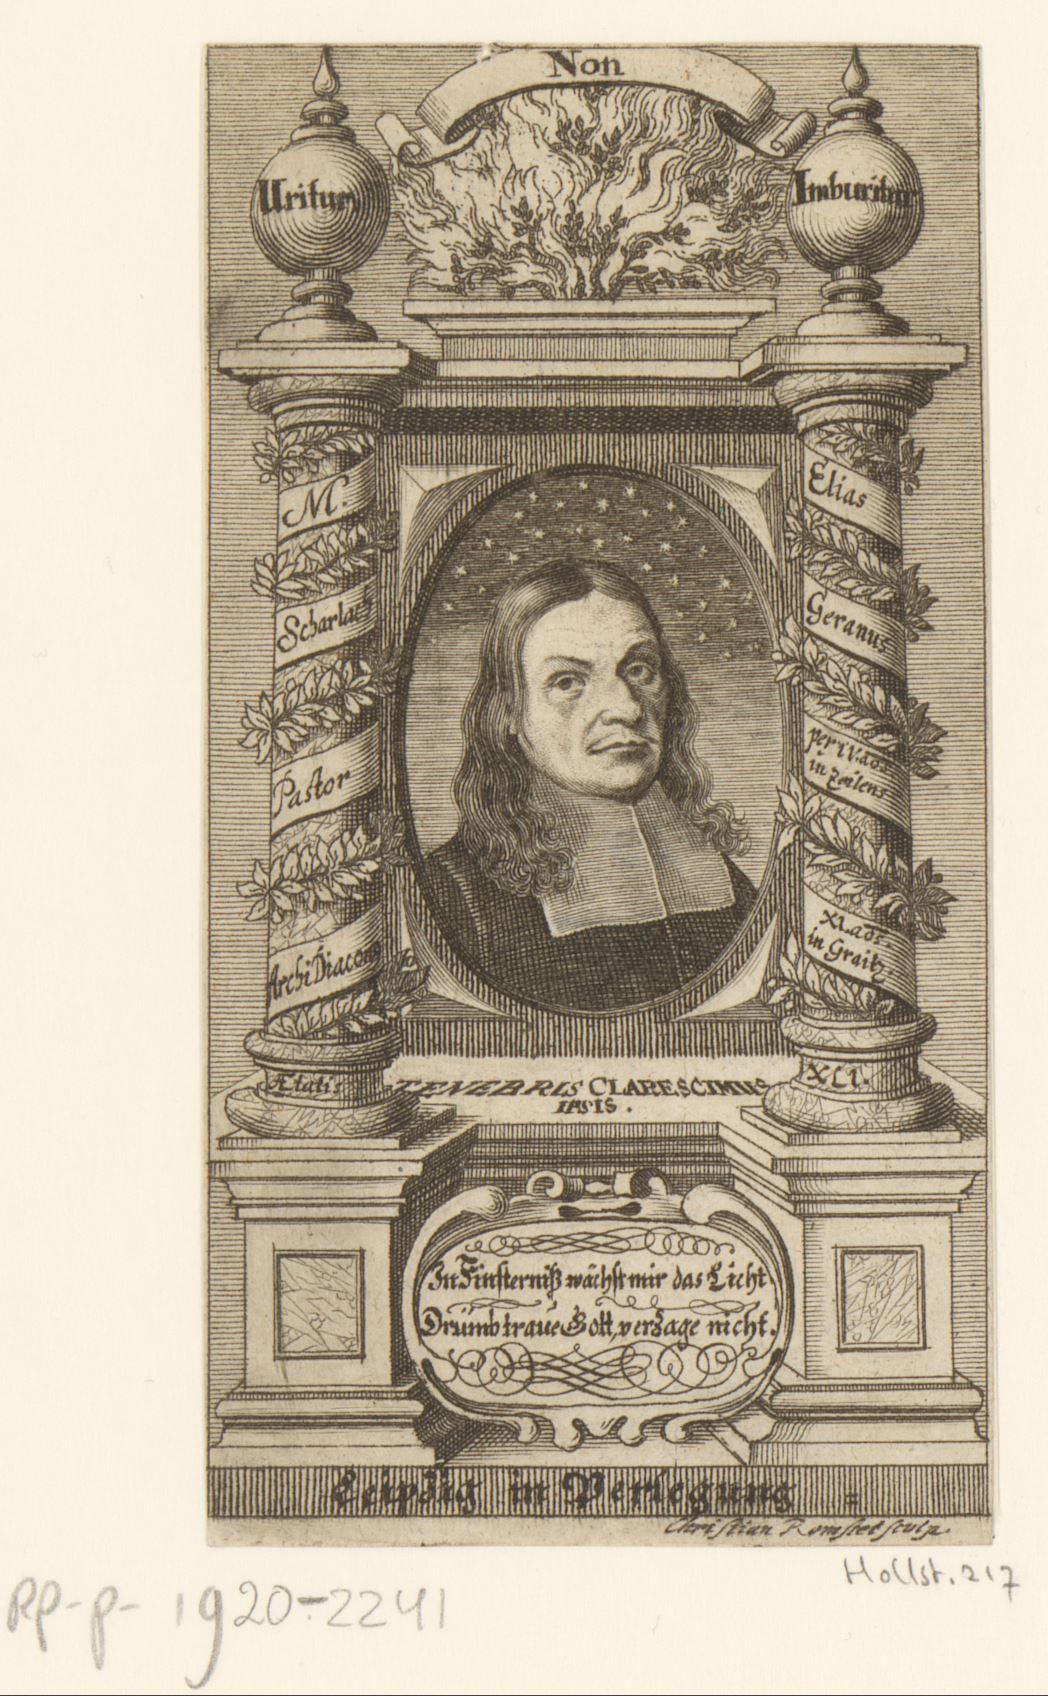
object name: print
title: Portret van Elias Scharlach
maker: christian romstet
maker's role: print maker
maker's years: 1640-1721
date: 1665-1721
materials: paper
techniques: engraving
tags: historical persons, flame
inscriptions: collector's mark: Lugt 2228